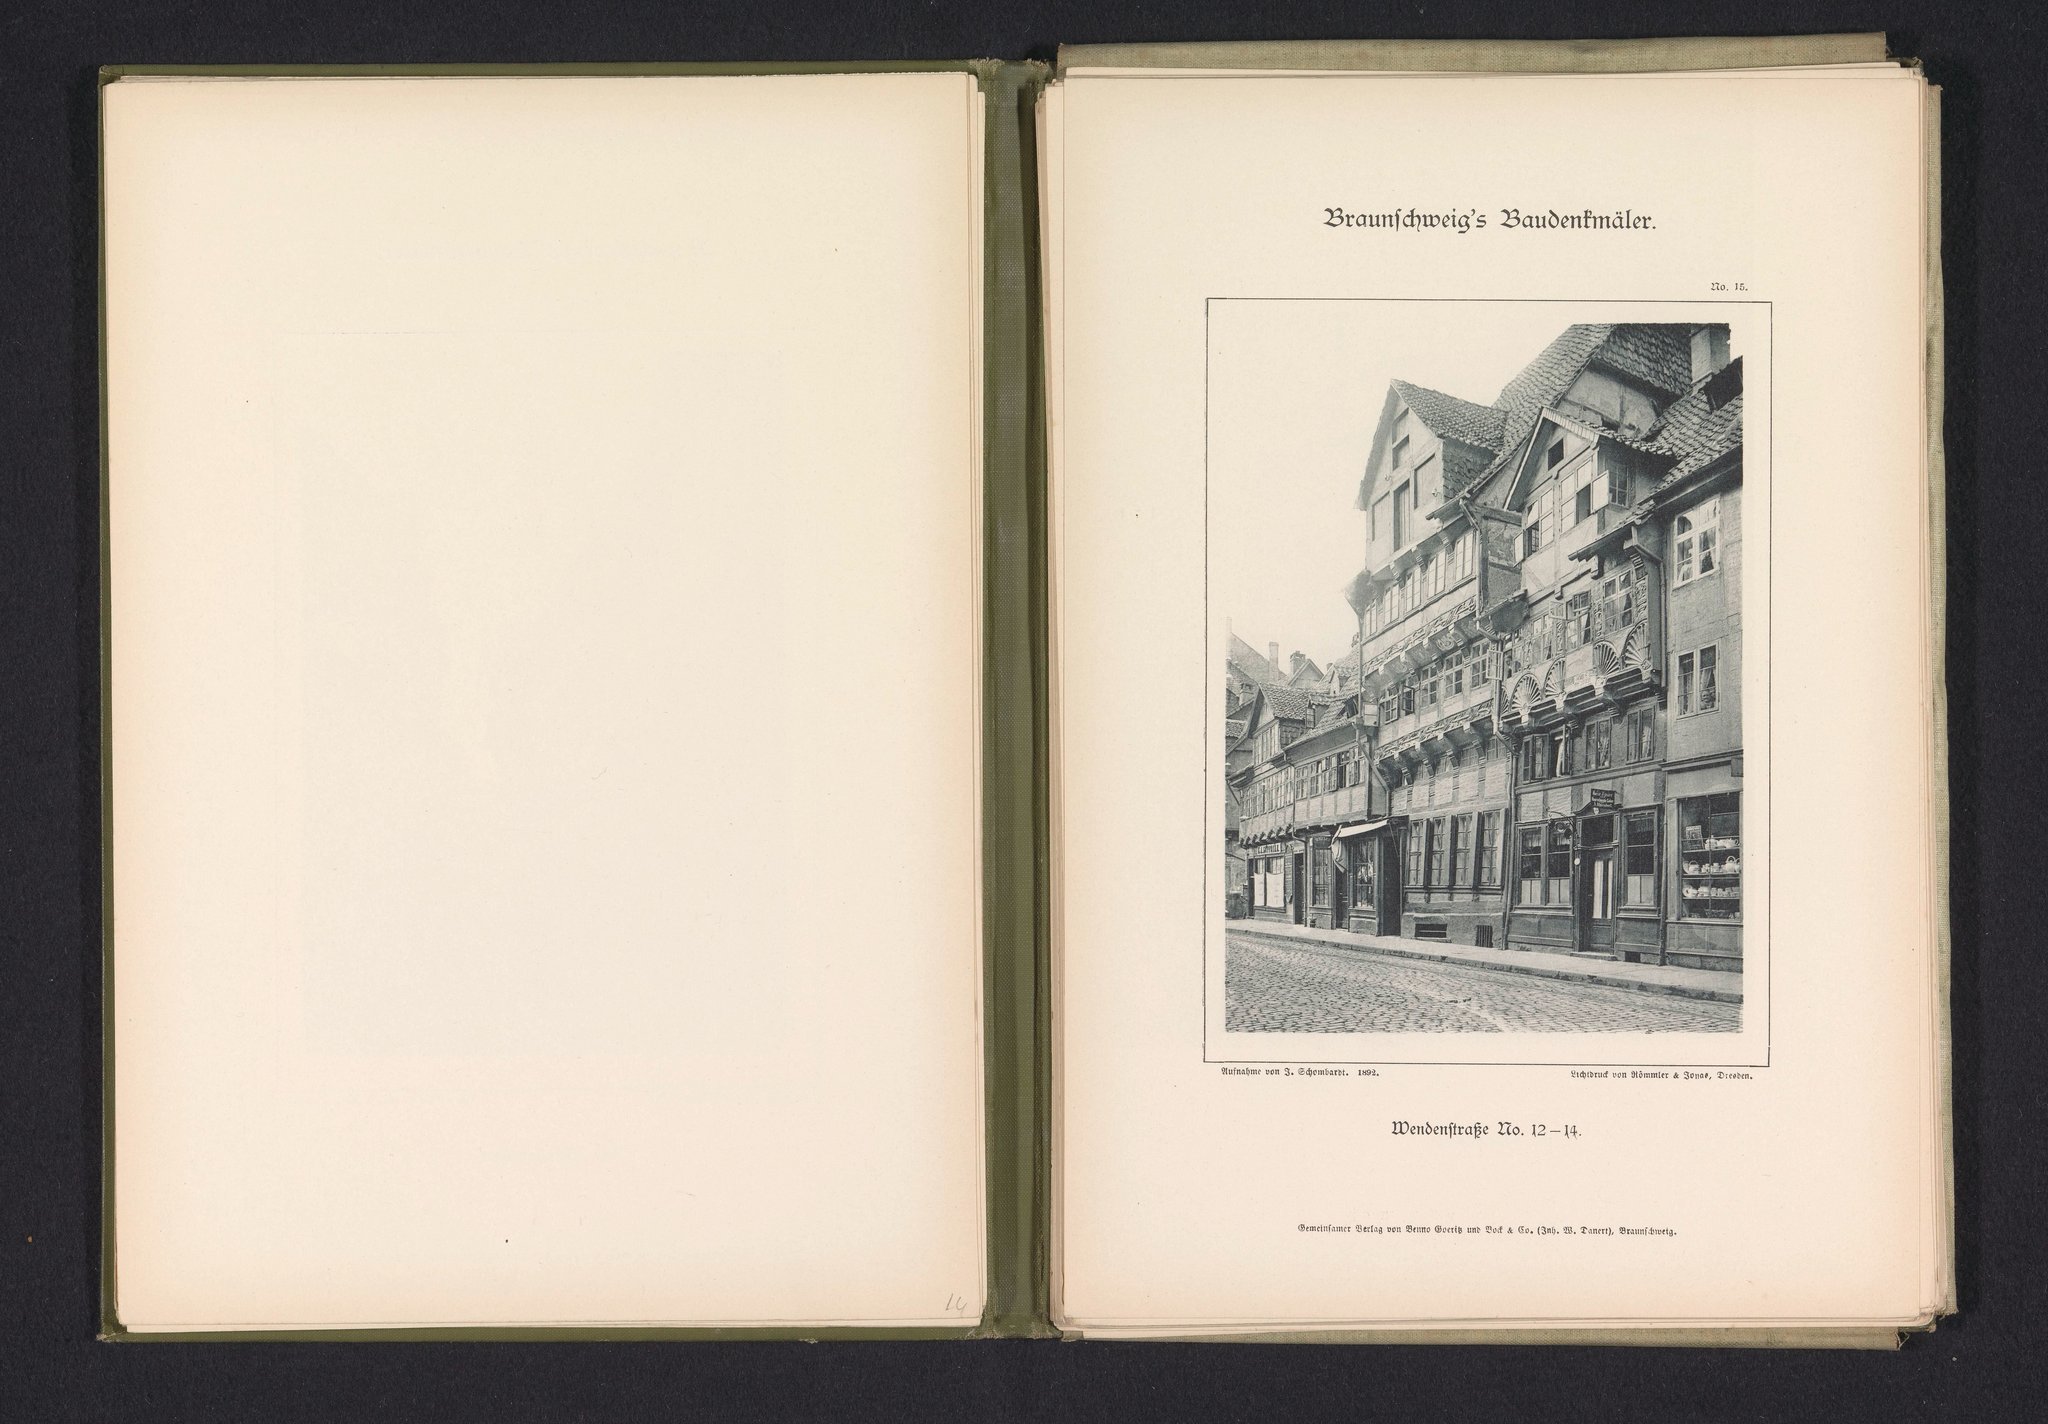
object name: photomechanical print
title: Exterieur van panden aan Wendenstraße 12 en 14 te Braunschweig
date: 1892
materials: paper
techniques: photograph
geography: braunschweig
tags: façade (of house or building), street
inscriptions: number: ‘No. 15.’